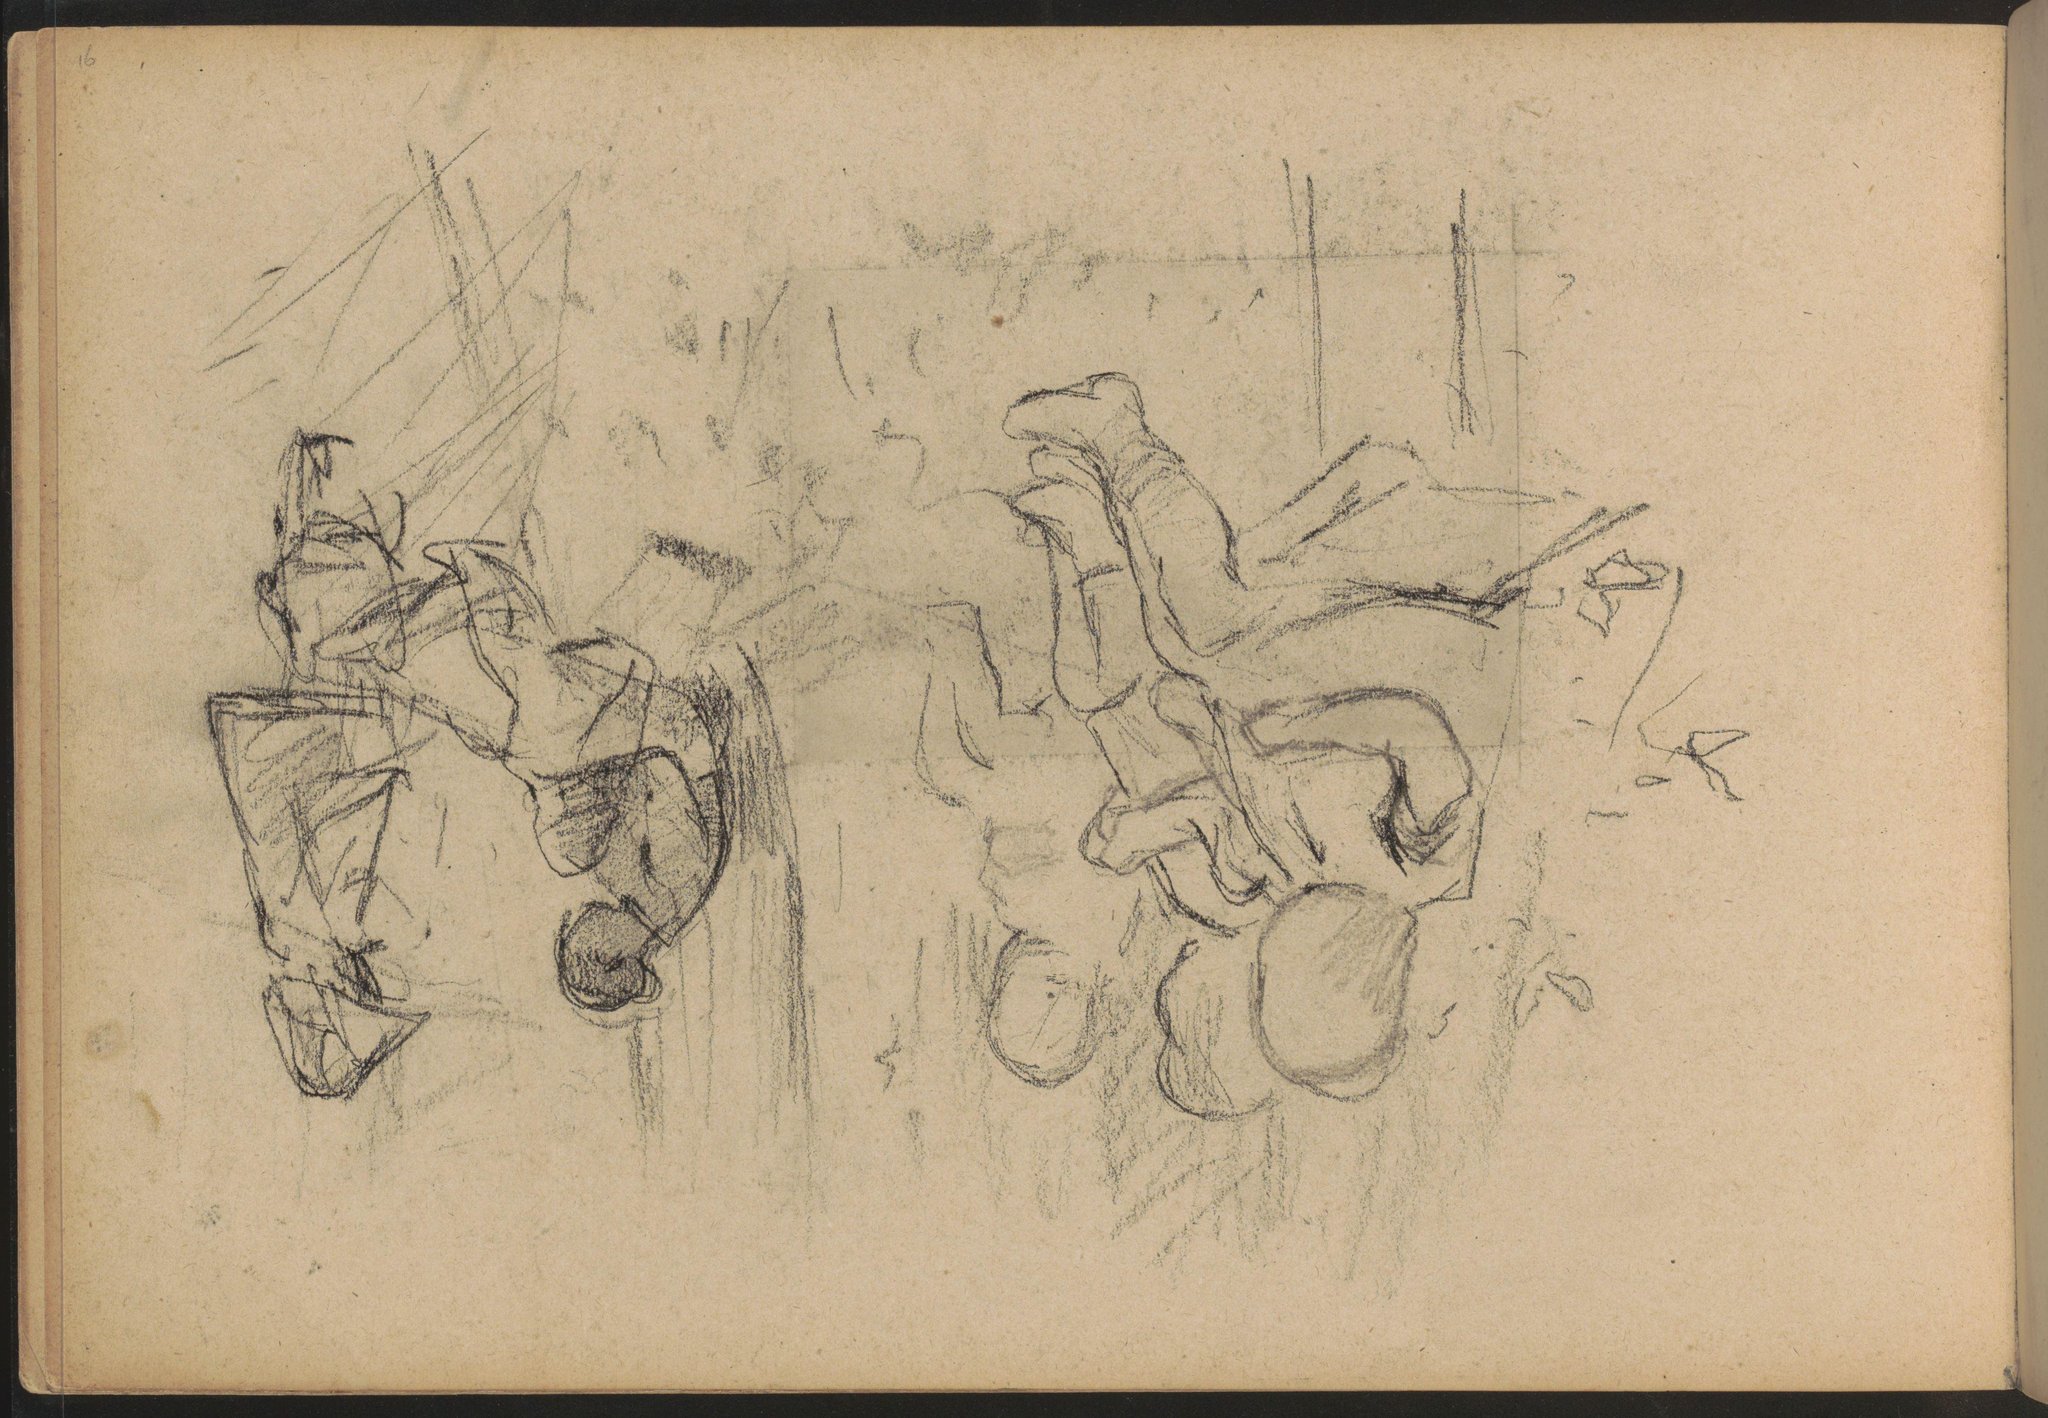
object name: sketchbook leaf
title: Studieblad met zittende kinderen en een vrouw met kind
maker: willem witsen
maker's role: draughtsman, painter, print maker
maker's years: 1860-1923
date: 1884-1887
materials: chalk, paper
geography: ewijkshoeve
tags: child (+ standing), child (+ sitting), mother and child(ren), woman and child(ren) (family group)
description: Pagina 16 uit een schetsboek met 29 bladen.